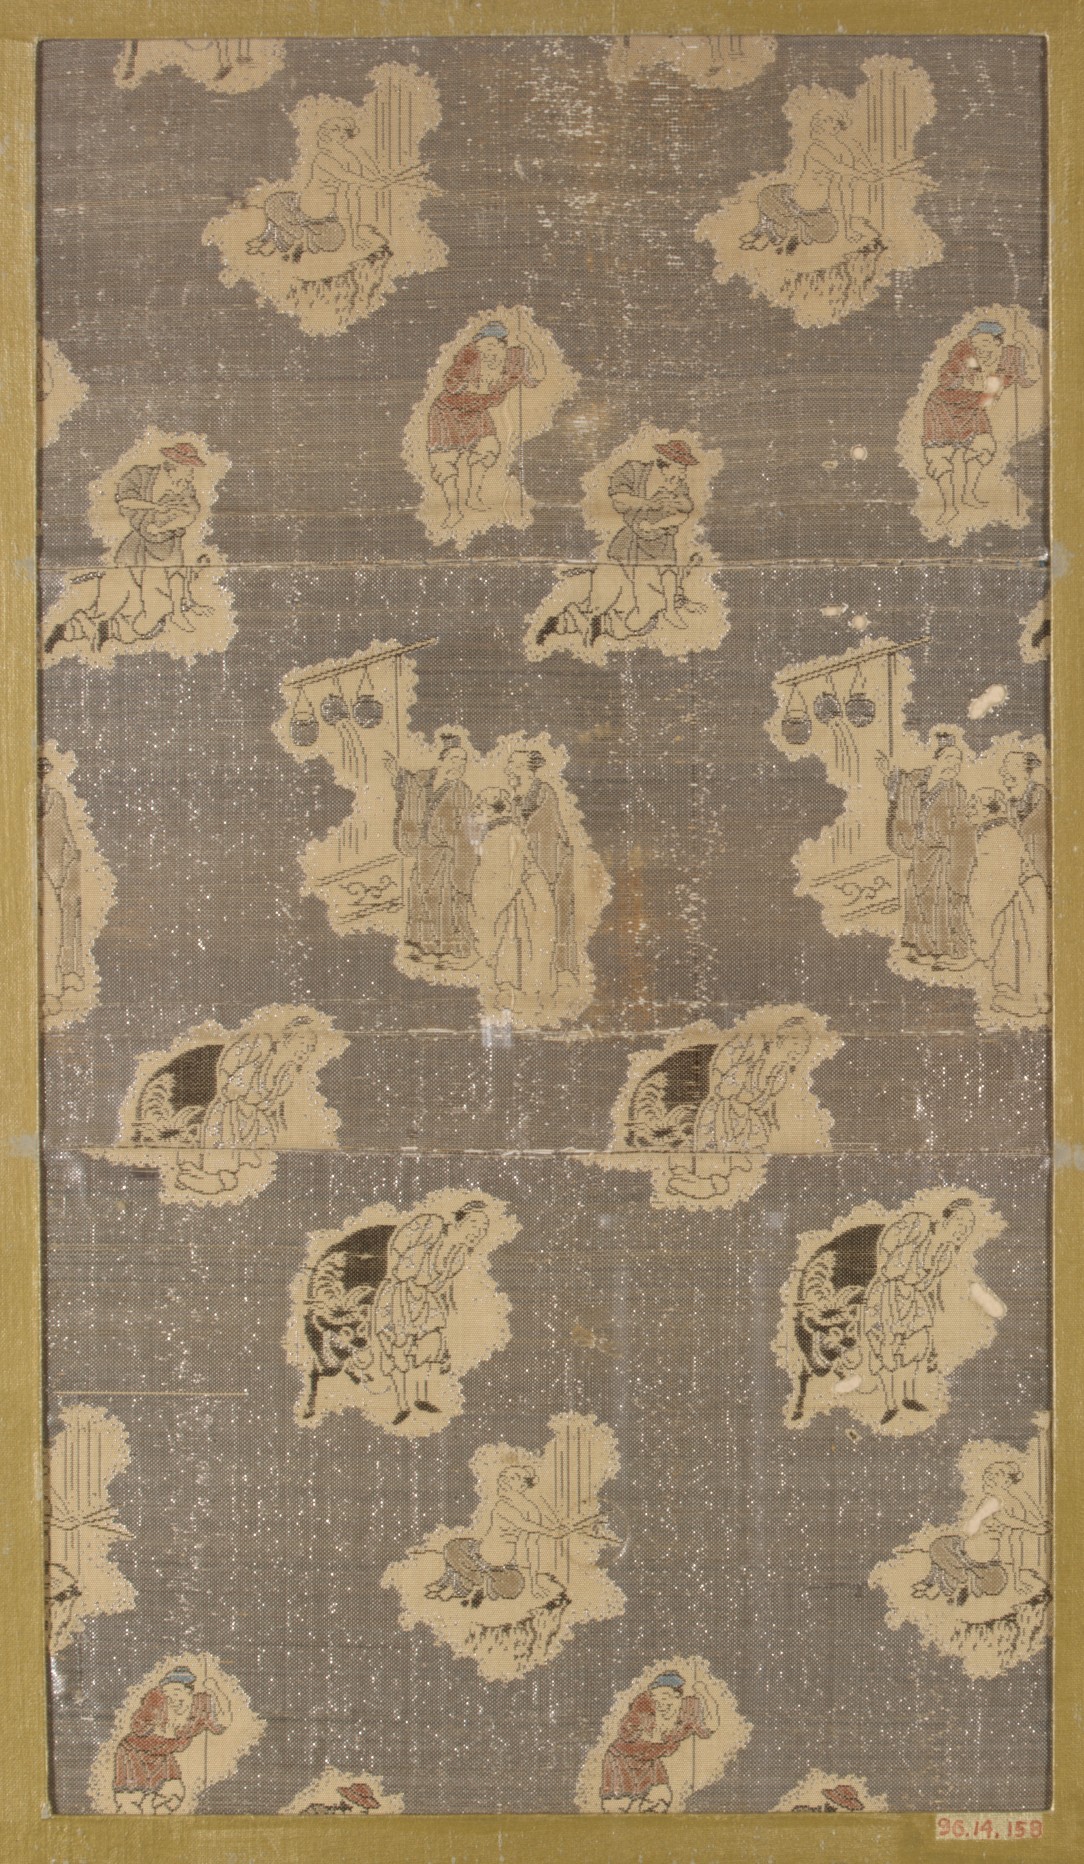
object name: fragment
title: Textile fragment with repeating pattern of scattered vignettes of human figures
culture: japanese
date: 1701-1900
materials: silk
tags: men